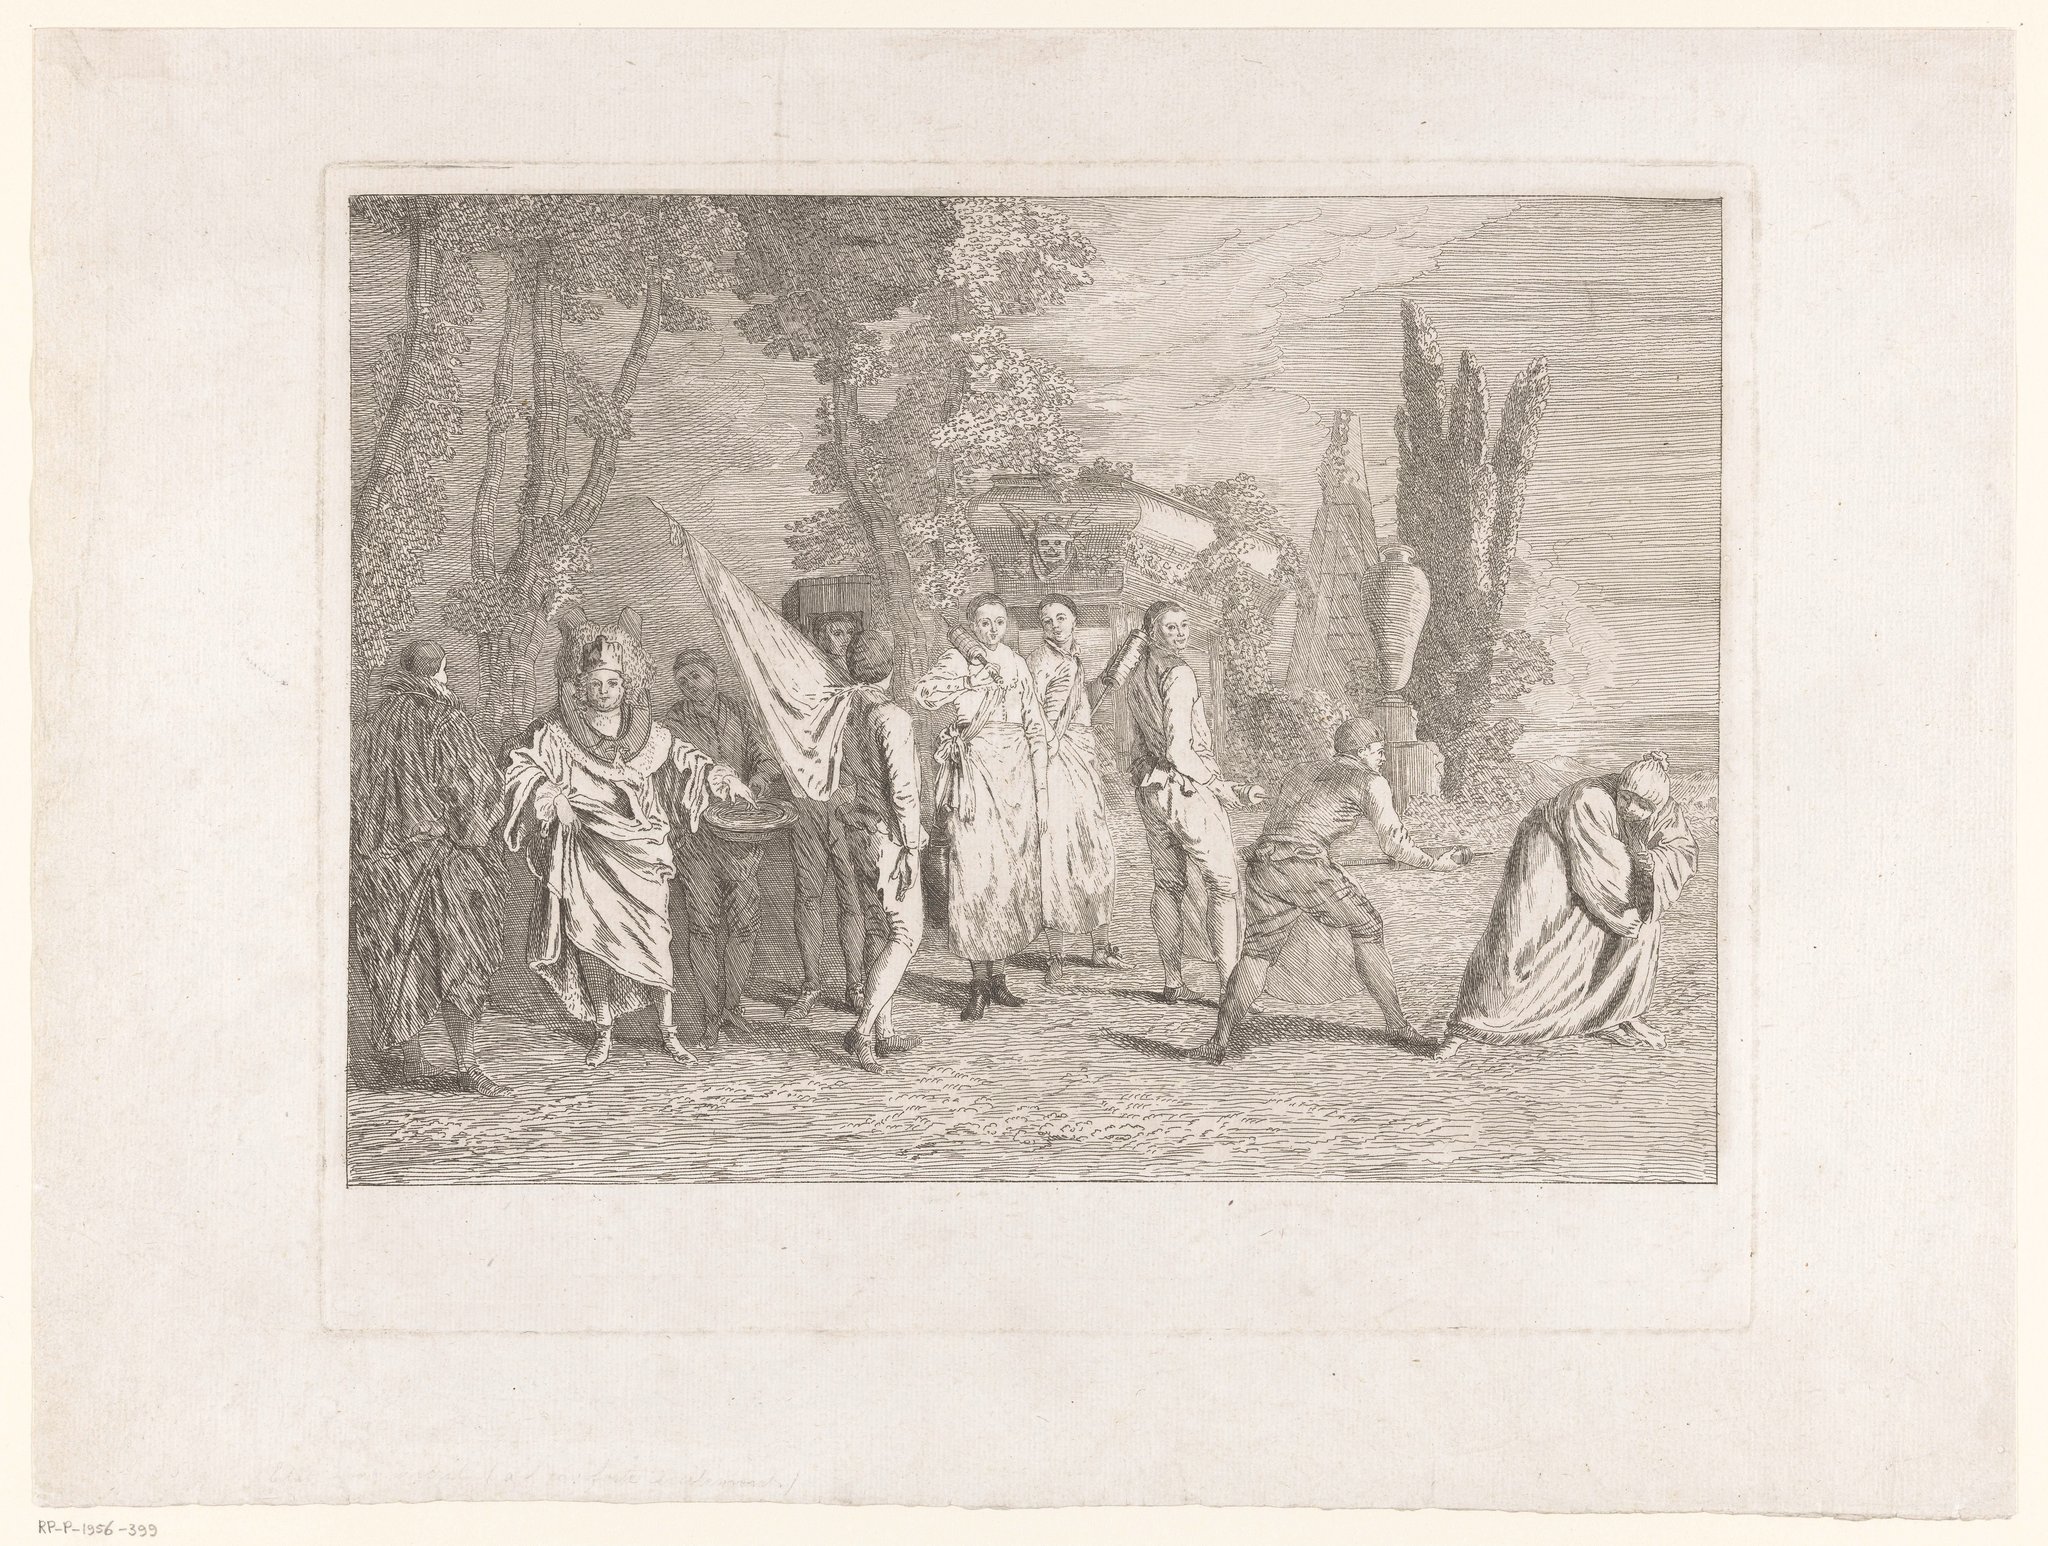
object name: print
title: Allegorische voorstelling waar ziekte wordt achtervolgd door de medicijnenfaculteit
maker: anne claude philippe caylus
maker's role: print maker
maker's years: 1692-1765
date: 1727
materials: paper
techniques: etching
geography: france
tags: escape, escape attempts, physician, doctor, patient, sick person, nursing, tending the sick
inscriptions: collector's mark: Lugt 2228